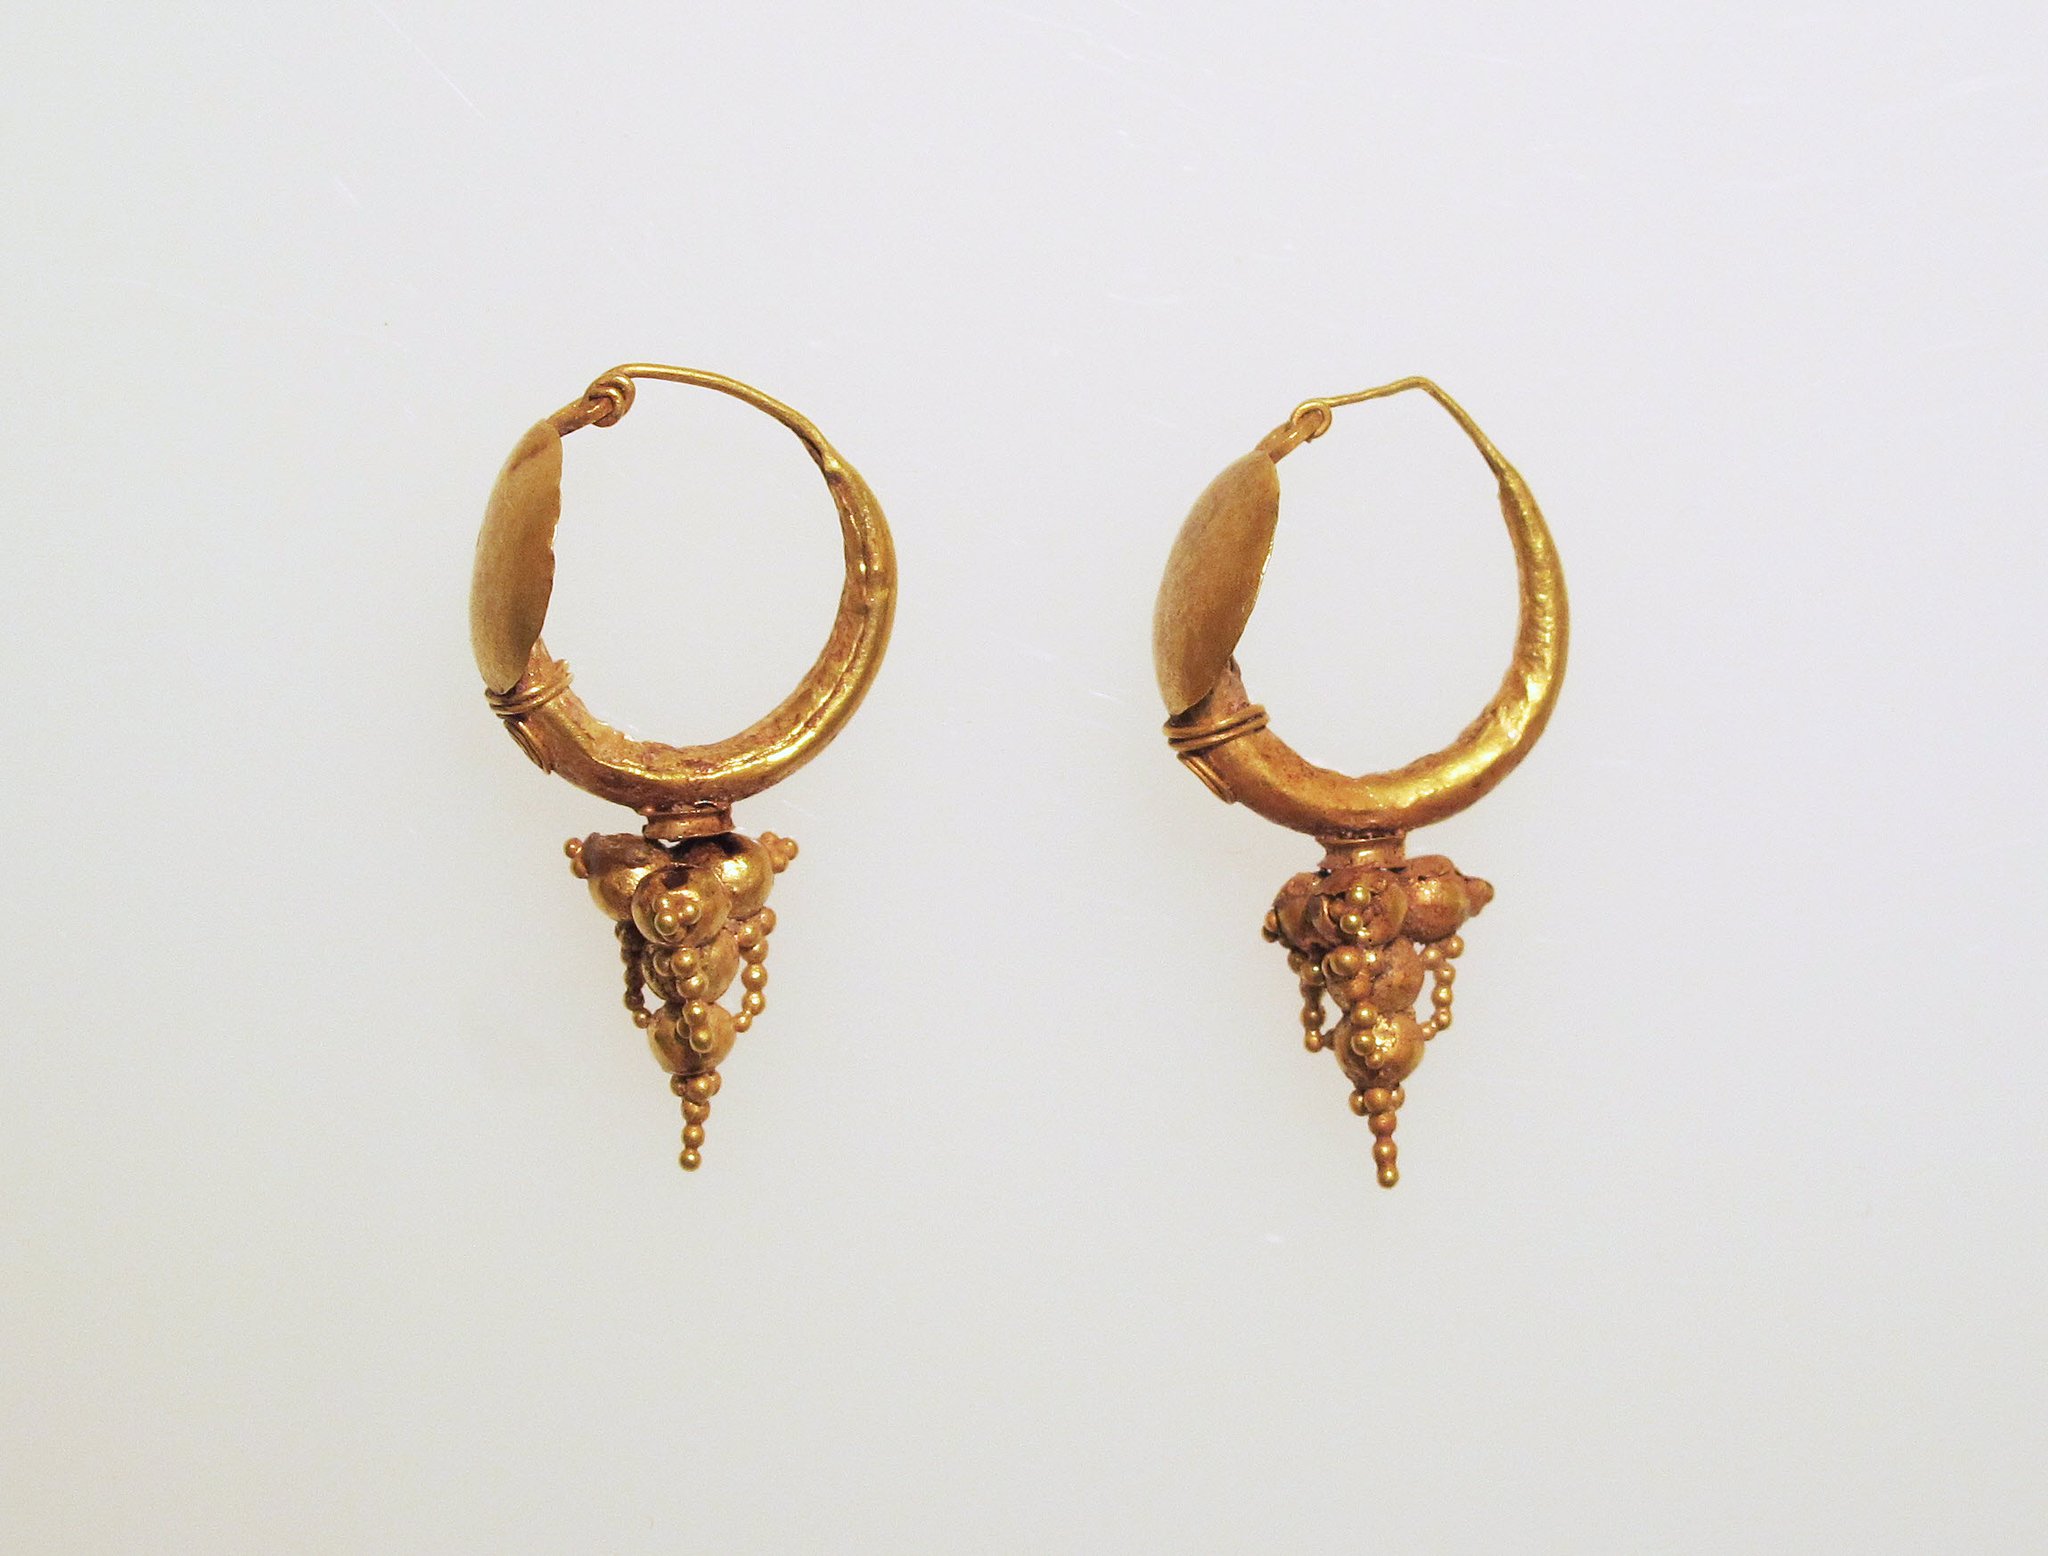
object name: earring with hook and eye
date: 7000 BCE-330 CE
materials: gold